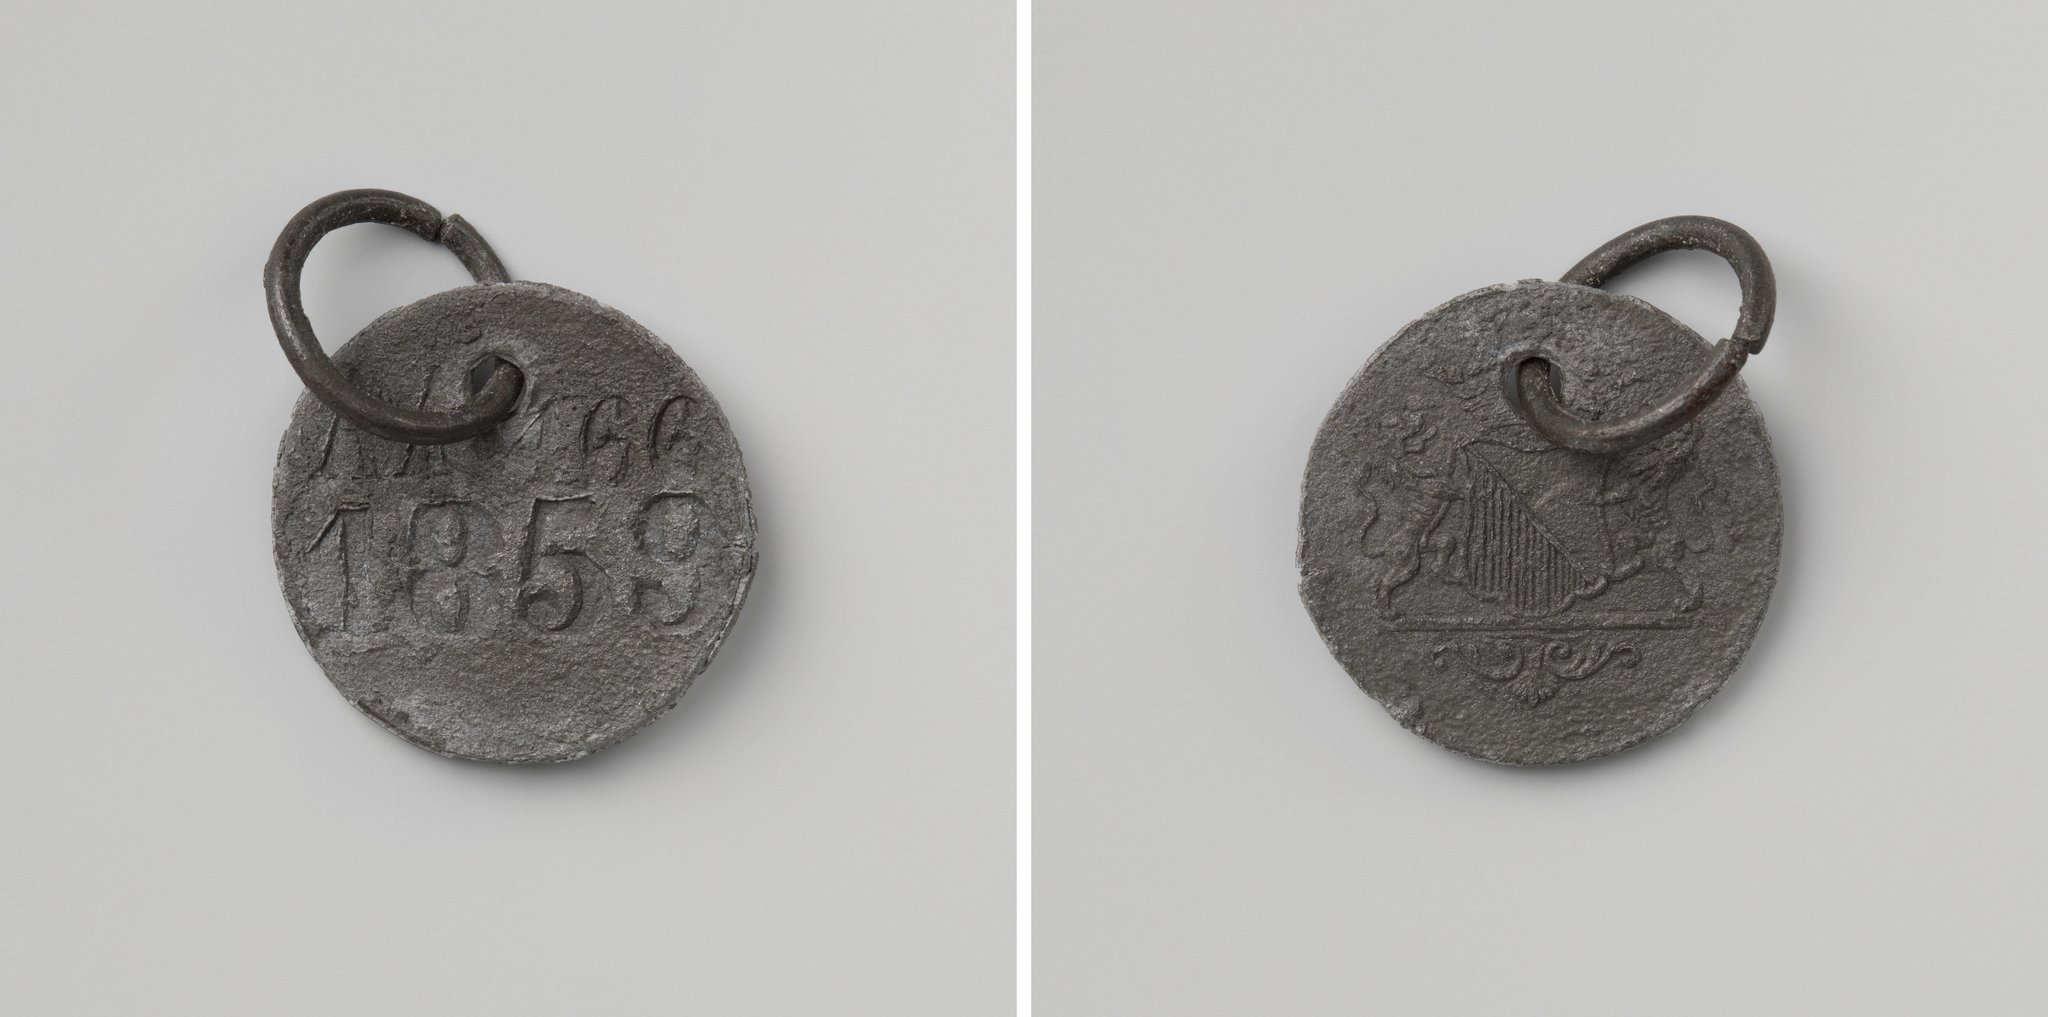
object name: tax token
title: Stad Utrecht, loodje met lettera AA en no. 466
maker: Anonymous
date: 1859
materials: lead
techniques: striking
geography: utrecht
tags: utrecht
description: loodje met gat erin aan draagring. Voorzijde: letters AA en cijfer 466 boven jaartal. Keerzijde: gekroond wapenschild, geflankeerd door twee leeuwen